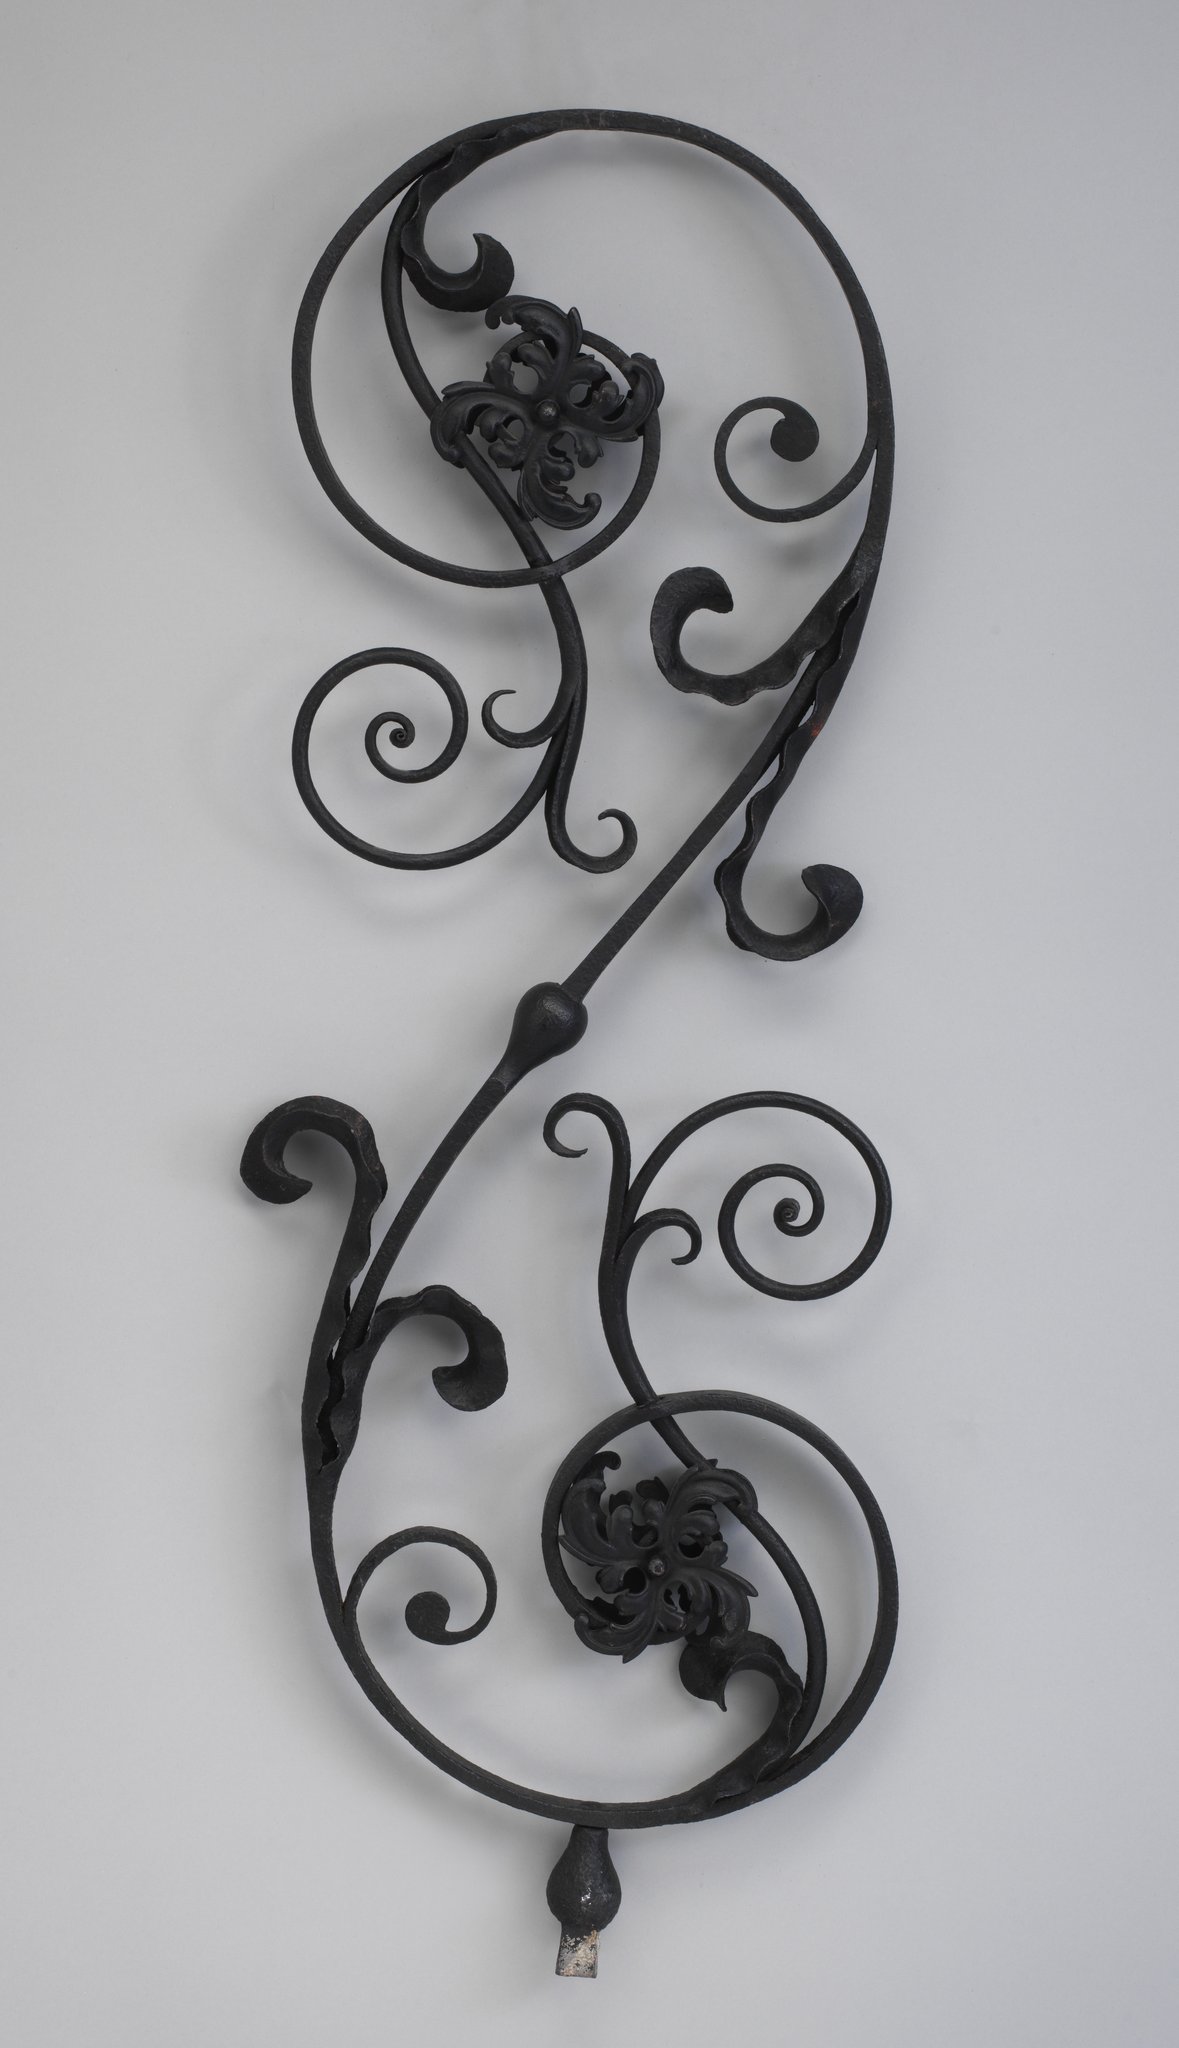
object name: baluster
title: Iron baluster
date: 1750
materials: iron